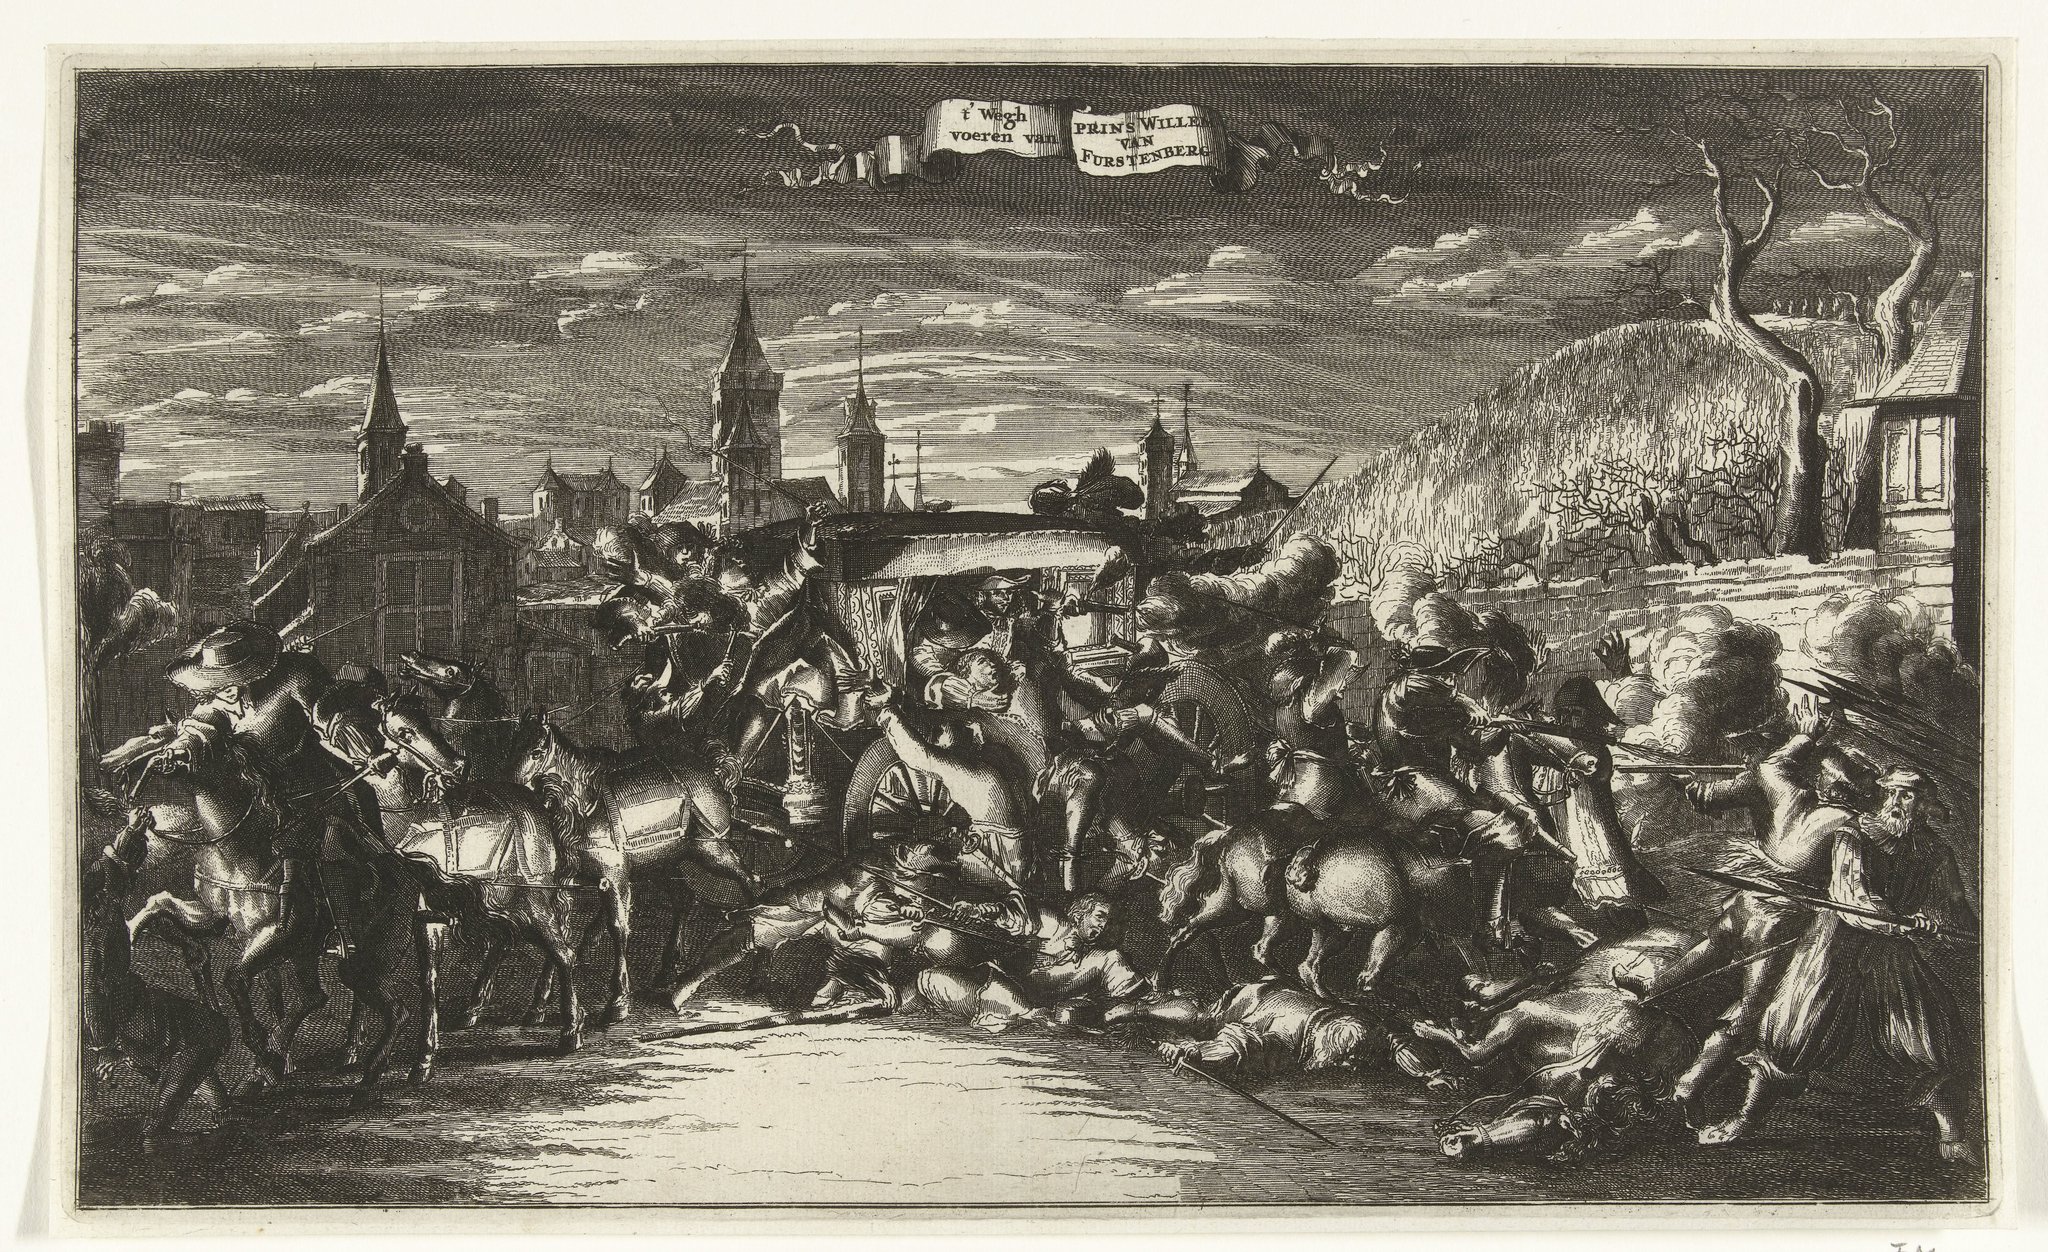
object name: print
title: t' Wegh voeren van Prins Willem van Furstenberg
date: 1674-1675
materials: paper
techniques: etching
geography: northern netherlands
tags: paris, abducting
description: Gebruikt als illustratie in: Lambert van den Bosch, Tooneel des oorlogs, opgerecht in de Vereenigde Nederlanden door de wapenen van de koningen van Vrankryk en Engeland, Keulsche en Munstersche bisschoppen : tegen de Staten der Vereenigde Nederlanden, en hare geallieerden, J. van Meurs en J. van Someren, Amsterdam 1675, 4 delen, dl. 4, fol. 179. Kopie naar de prent toegeschreven aan Romeyn de Hooghe, FMH 2525.